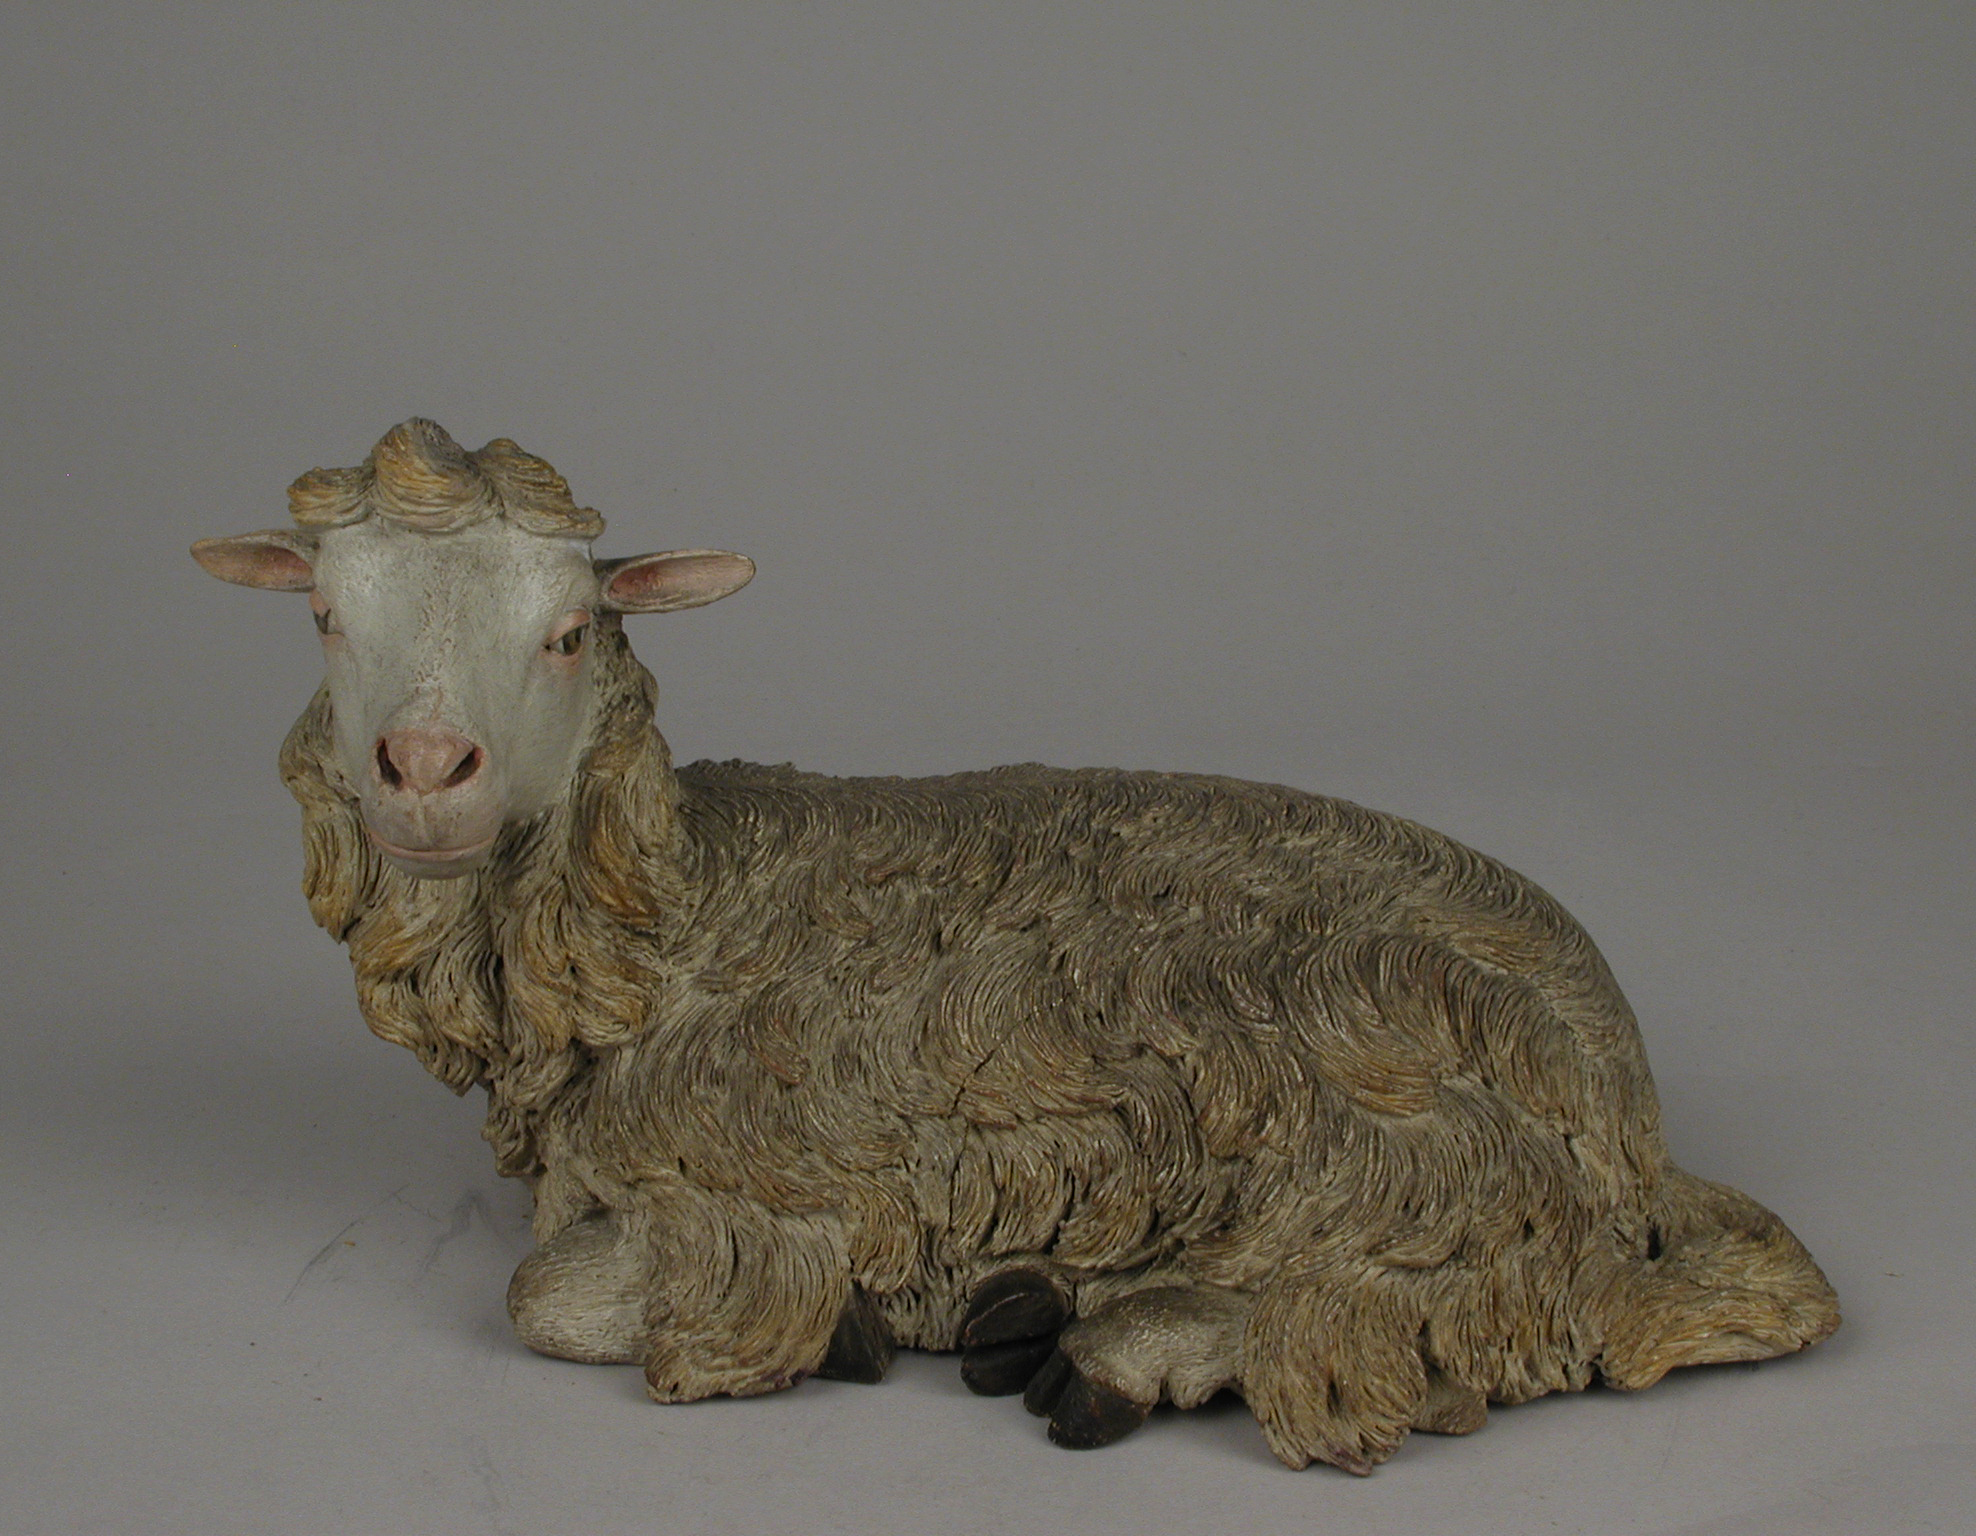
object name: crèche figure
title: Seated sheep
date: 1751-1800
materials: terracotta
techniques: polychrome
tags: sheep